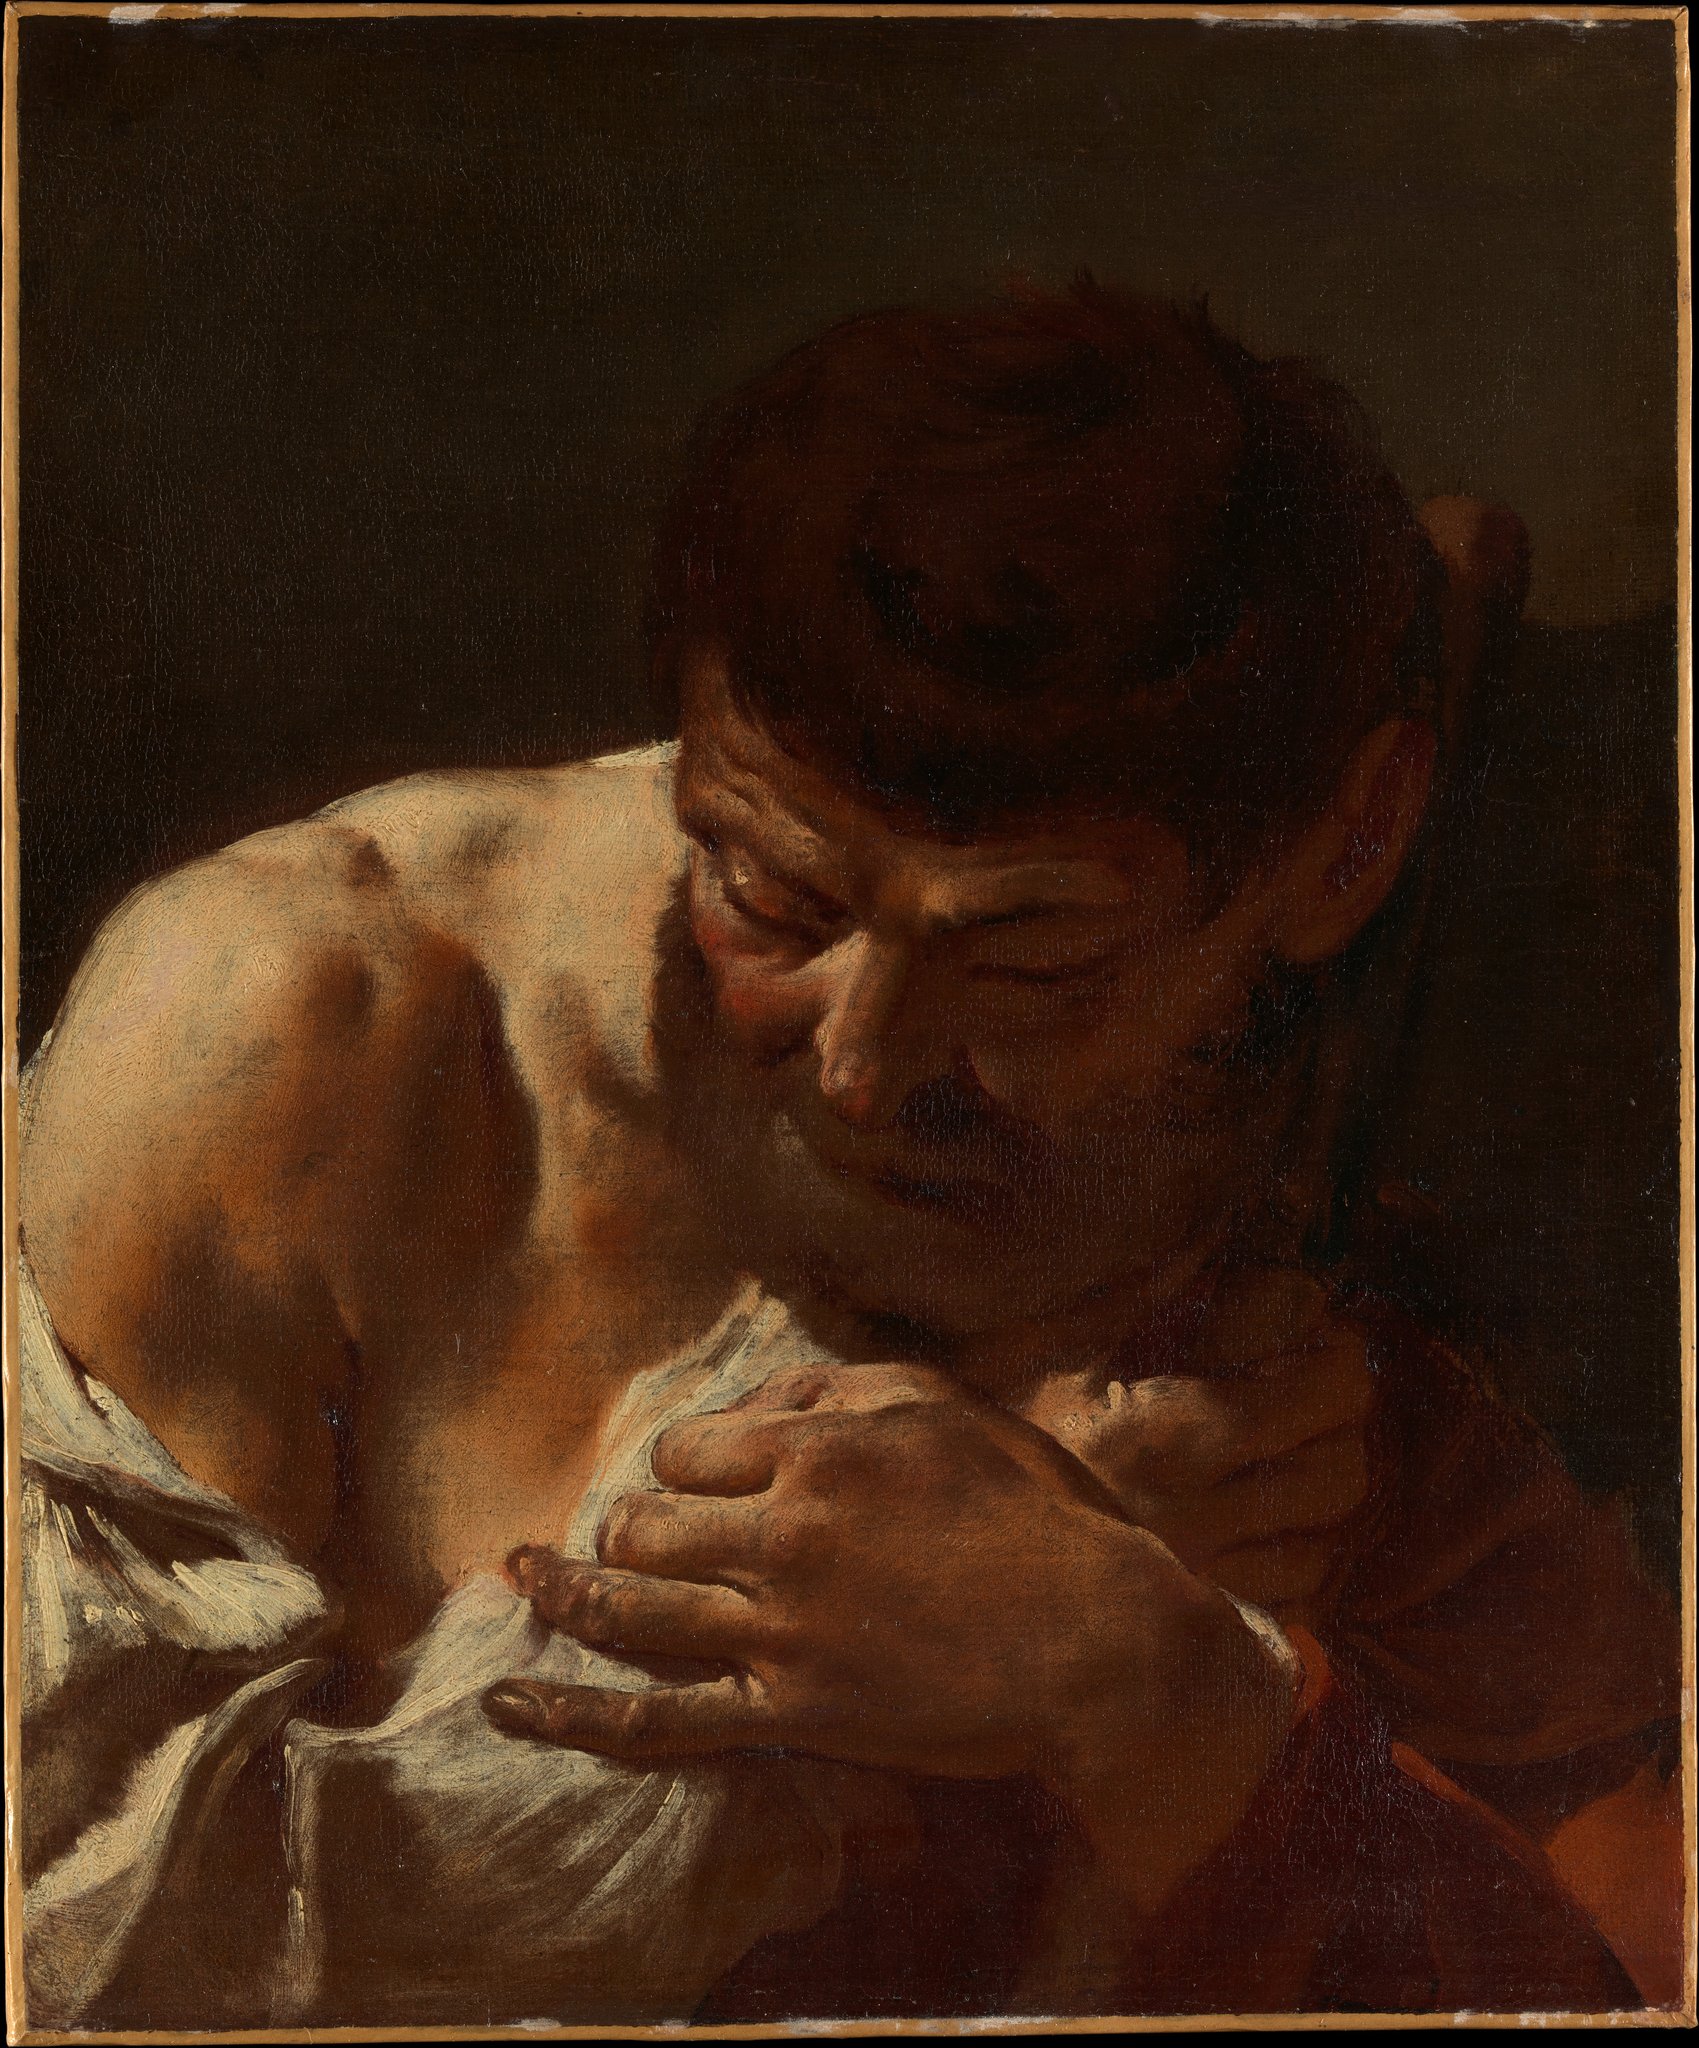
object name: painting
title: Bust of a Man (Saint Matthias?)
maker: giovanni battista piazzetta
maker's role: artist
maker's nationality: italian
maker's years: 1682-1754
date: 1715-1720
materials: canvas, oil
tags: men,portraits